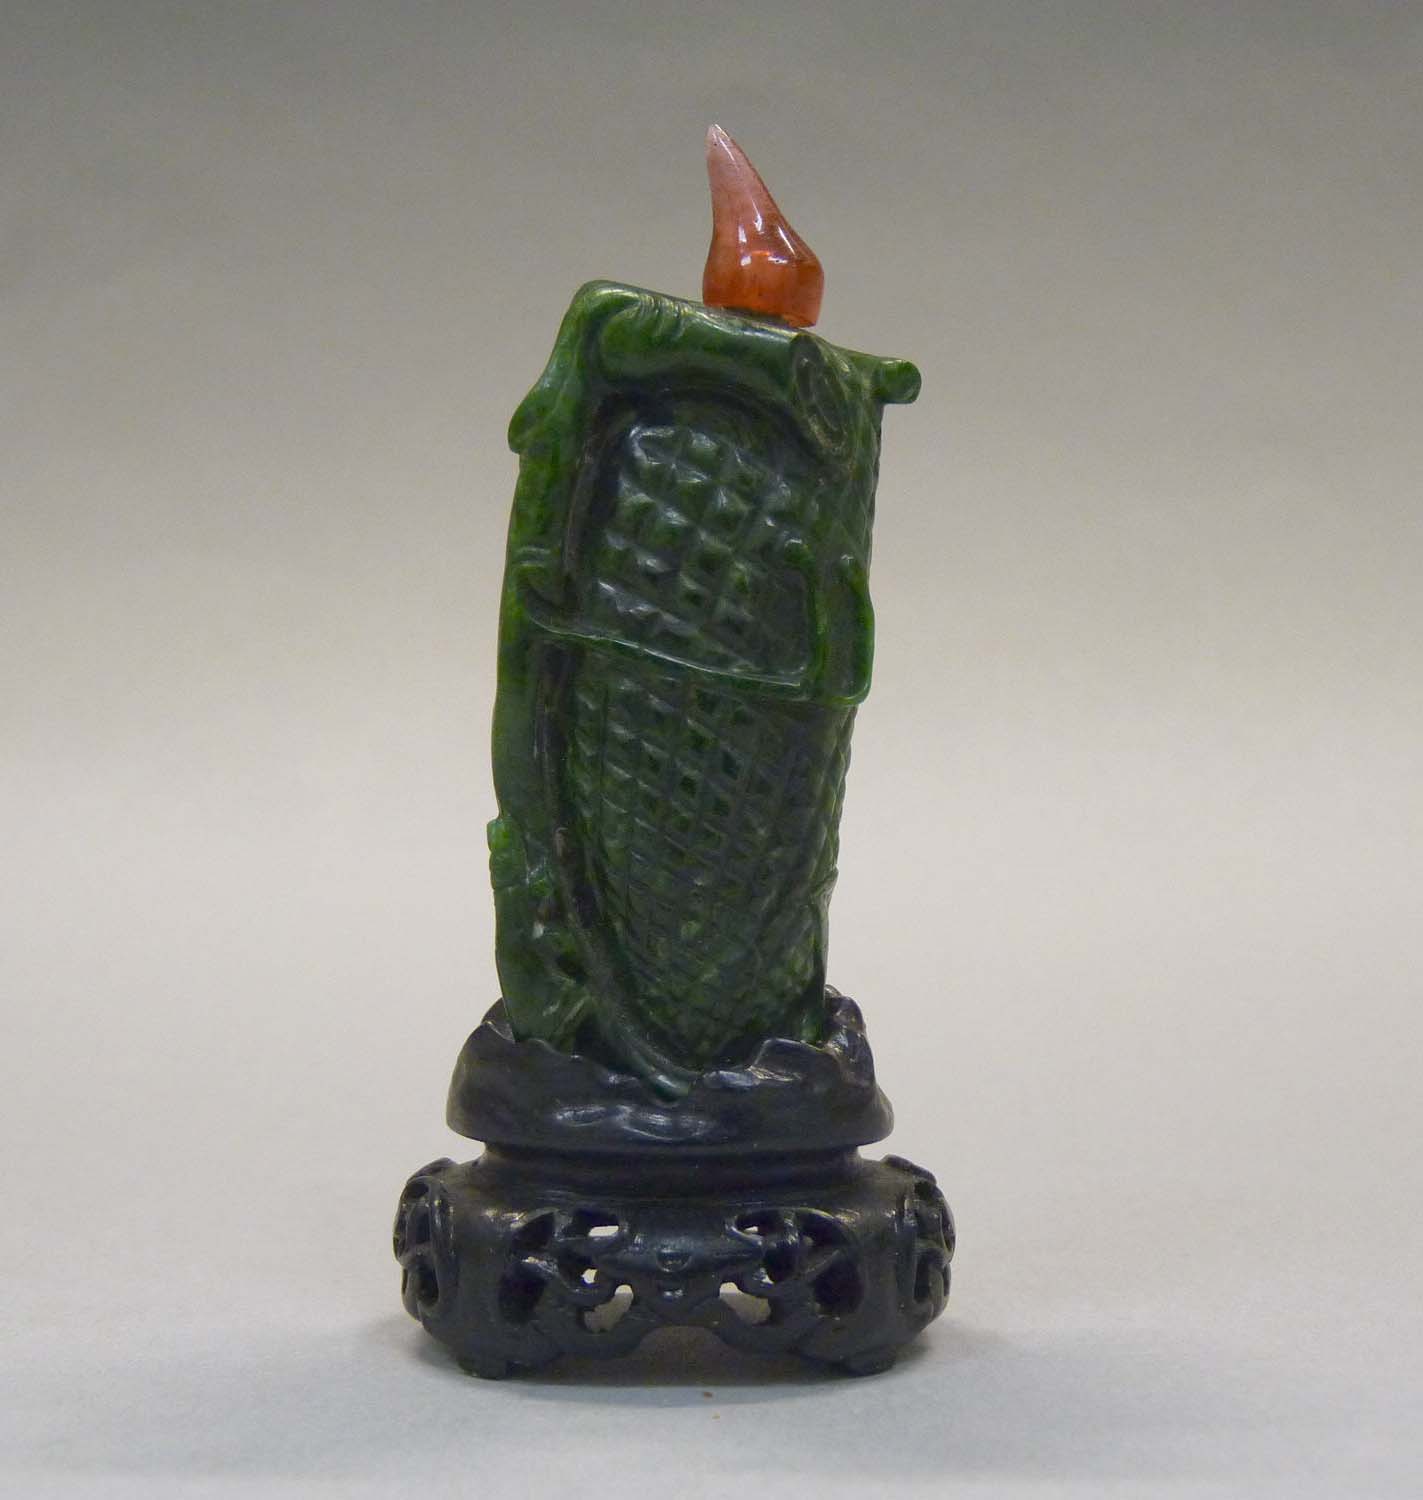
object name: snuff bottle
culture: chinese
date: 1736-1795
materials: glass, jade